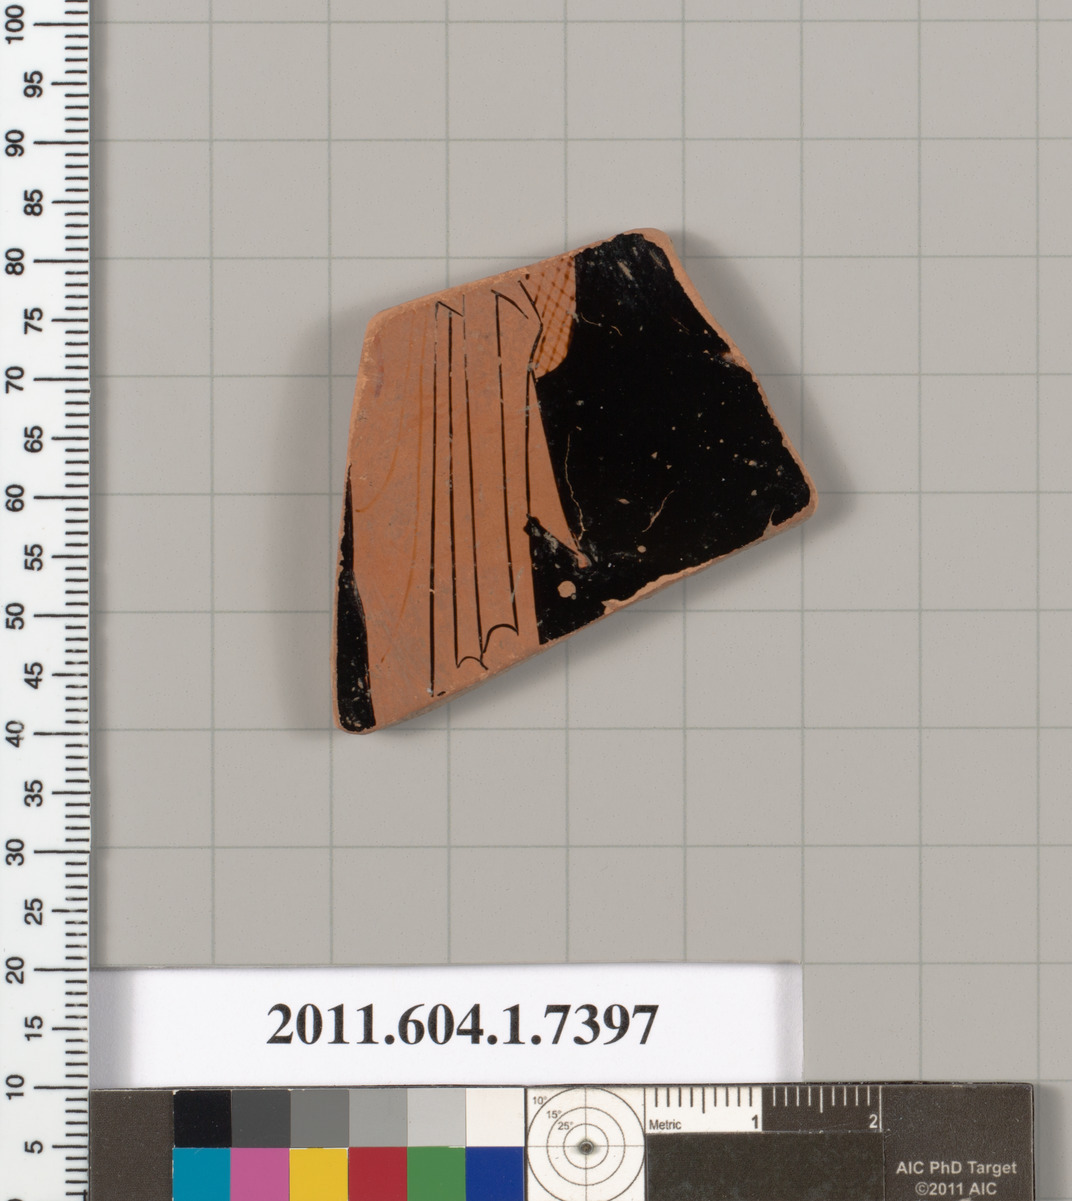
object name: kylix fragment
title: Terracotta fragment of a kylix (drinking cup)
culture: greek, attic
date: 500-480 BCE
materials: terracotta